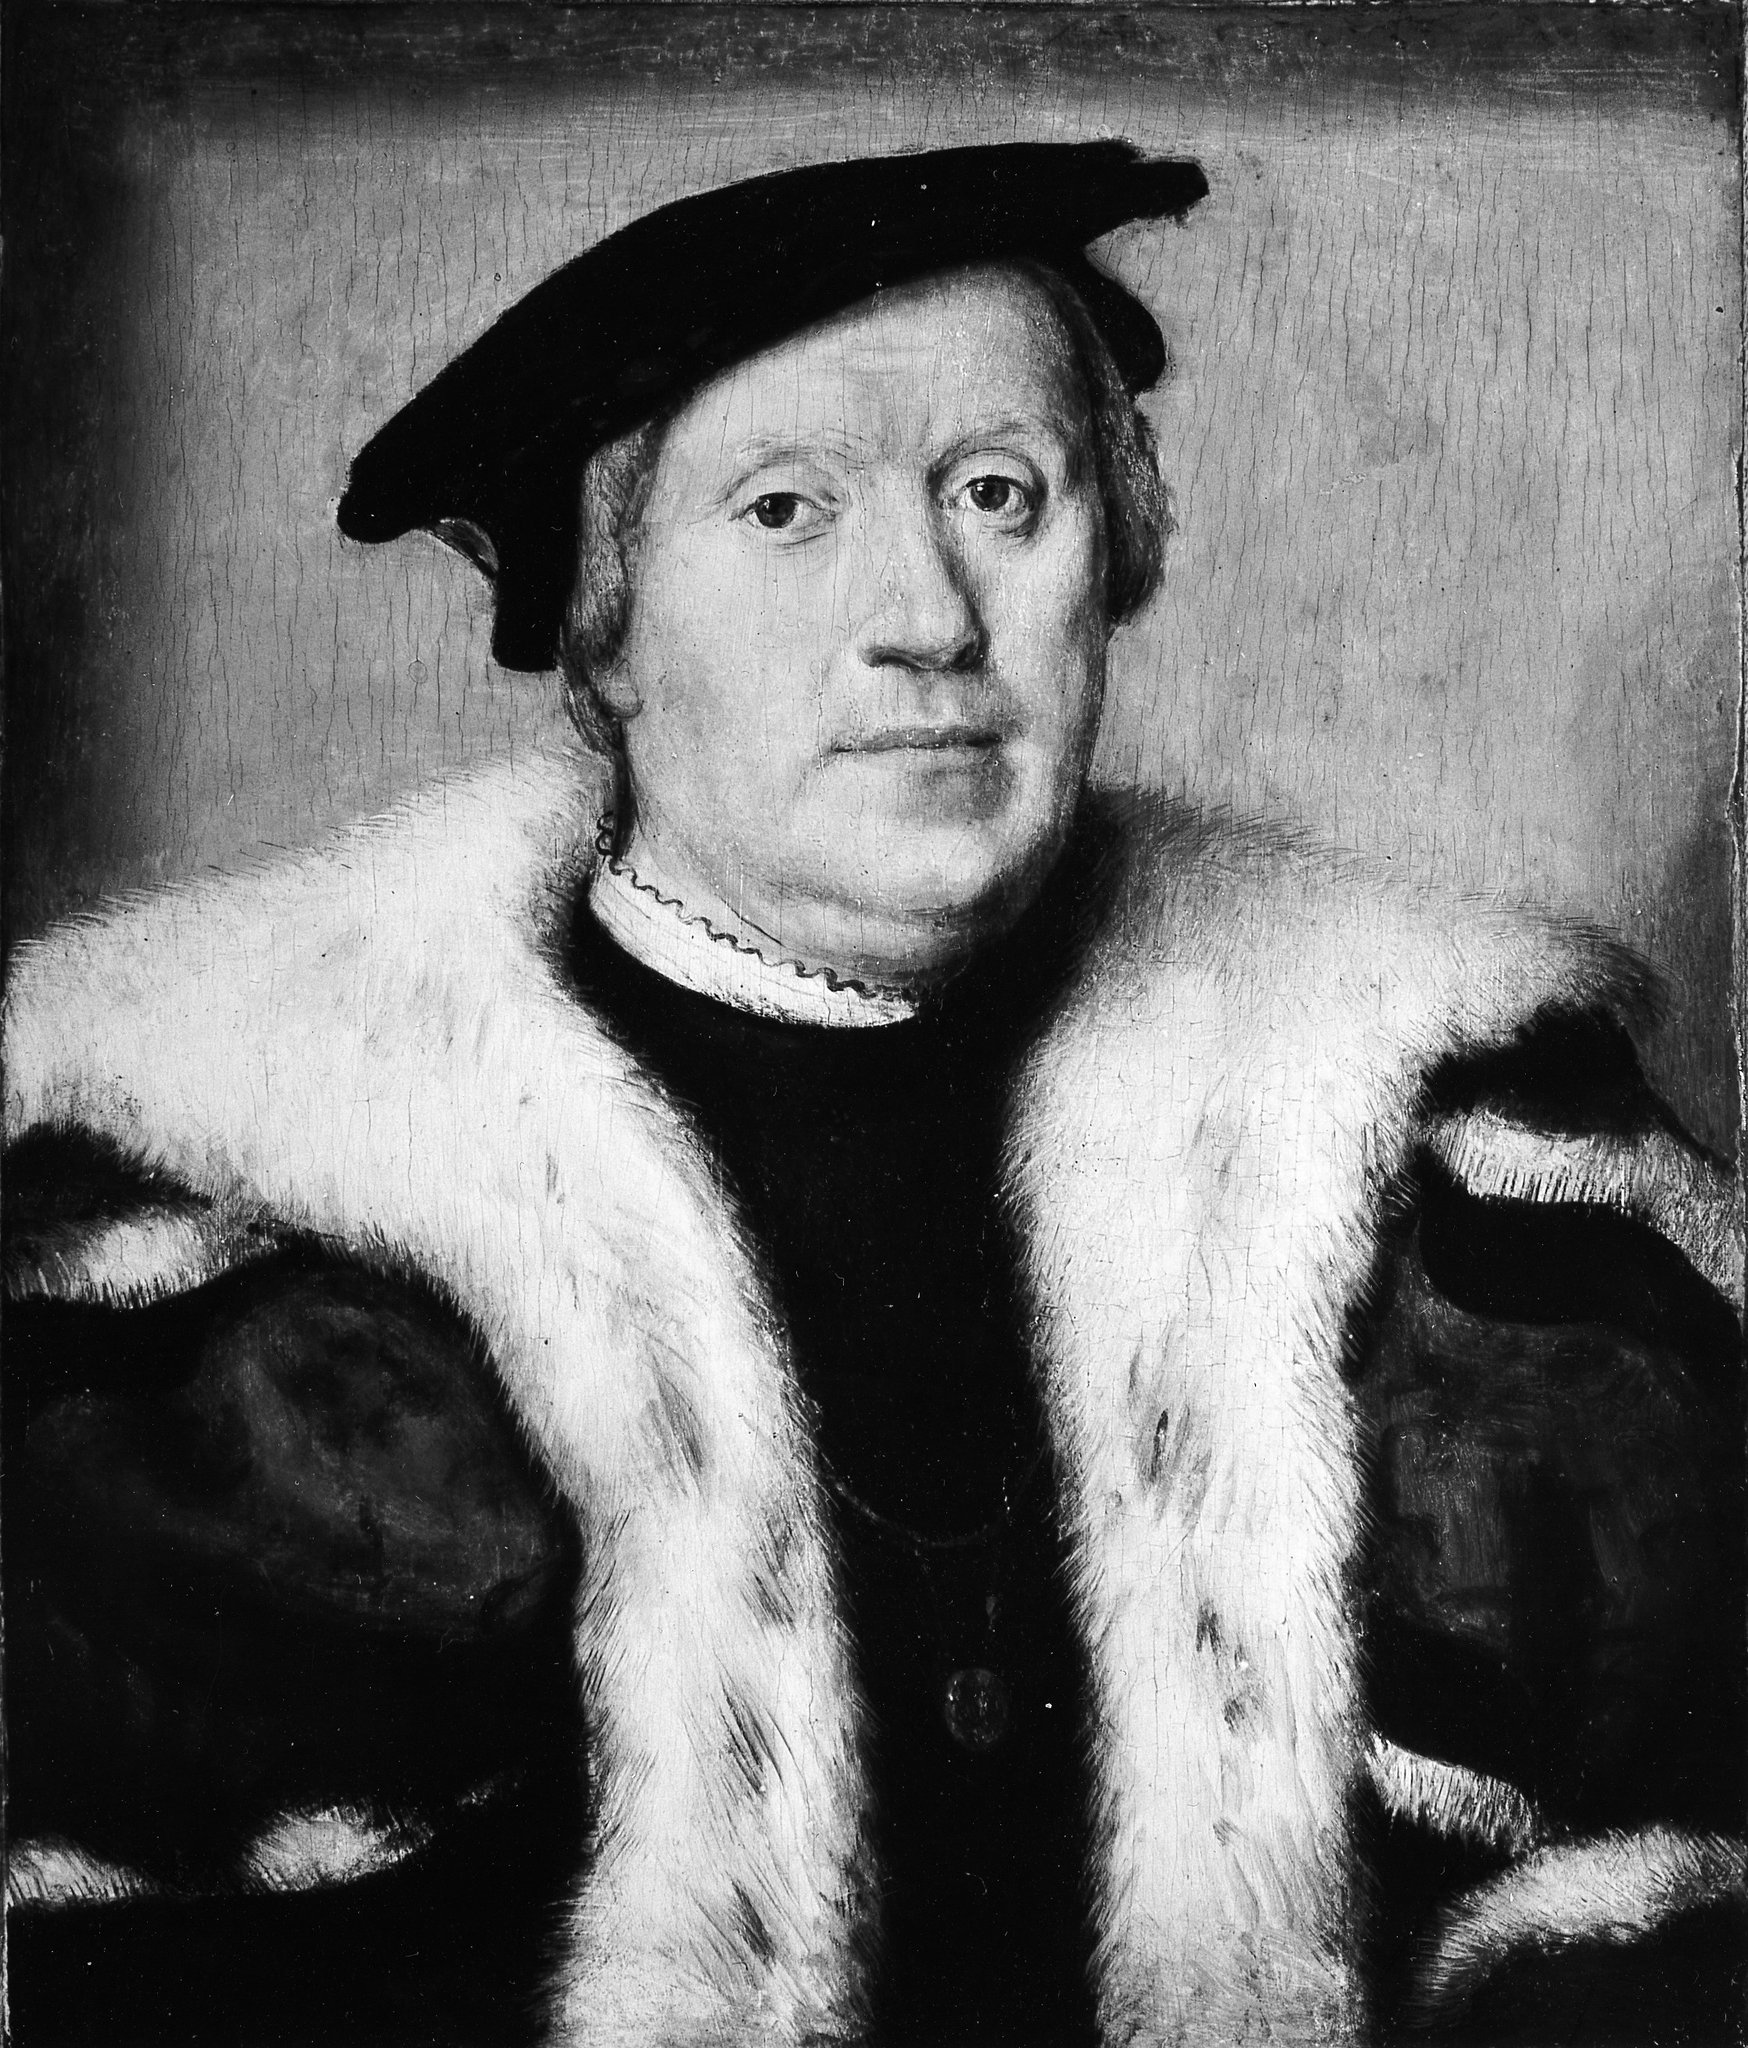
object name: painting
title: Jean d'Albon de Saint-André (1472–1549)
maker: corneille de lyon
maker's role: artist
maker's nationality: netherlandish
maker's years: 1533-1575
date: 1533-1575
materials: oil, wood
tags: men,portraits